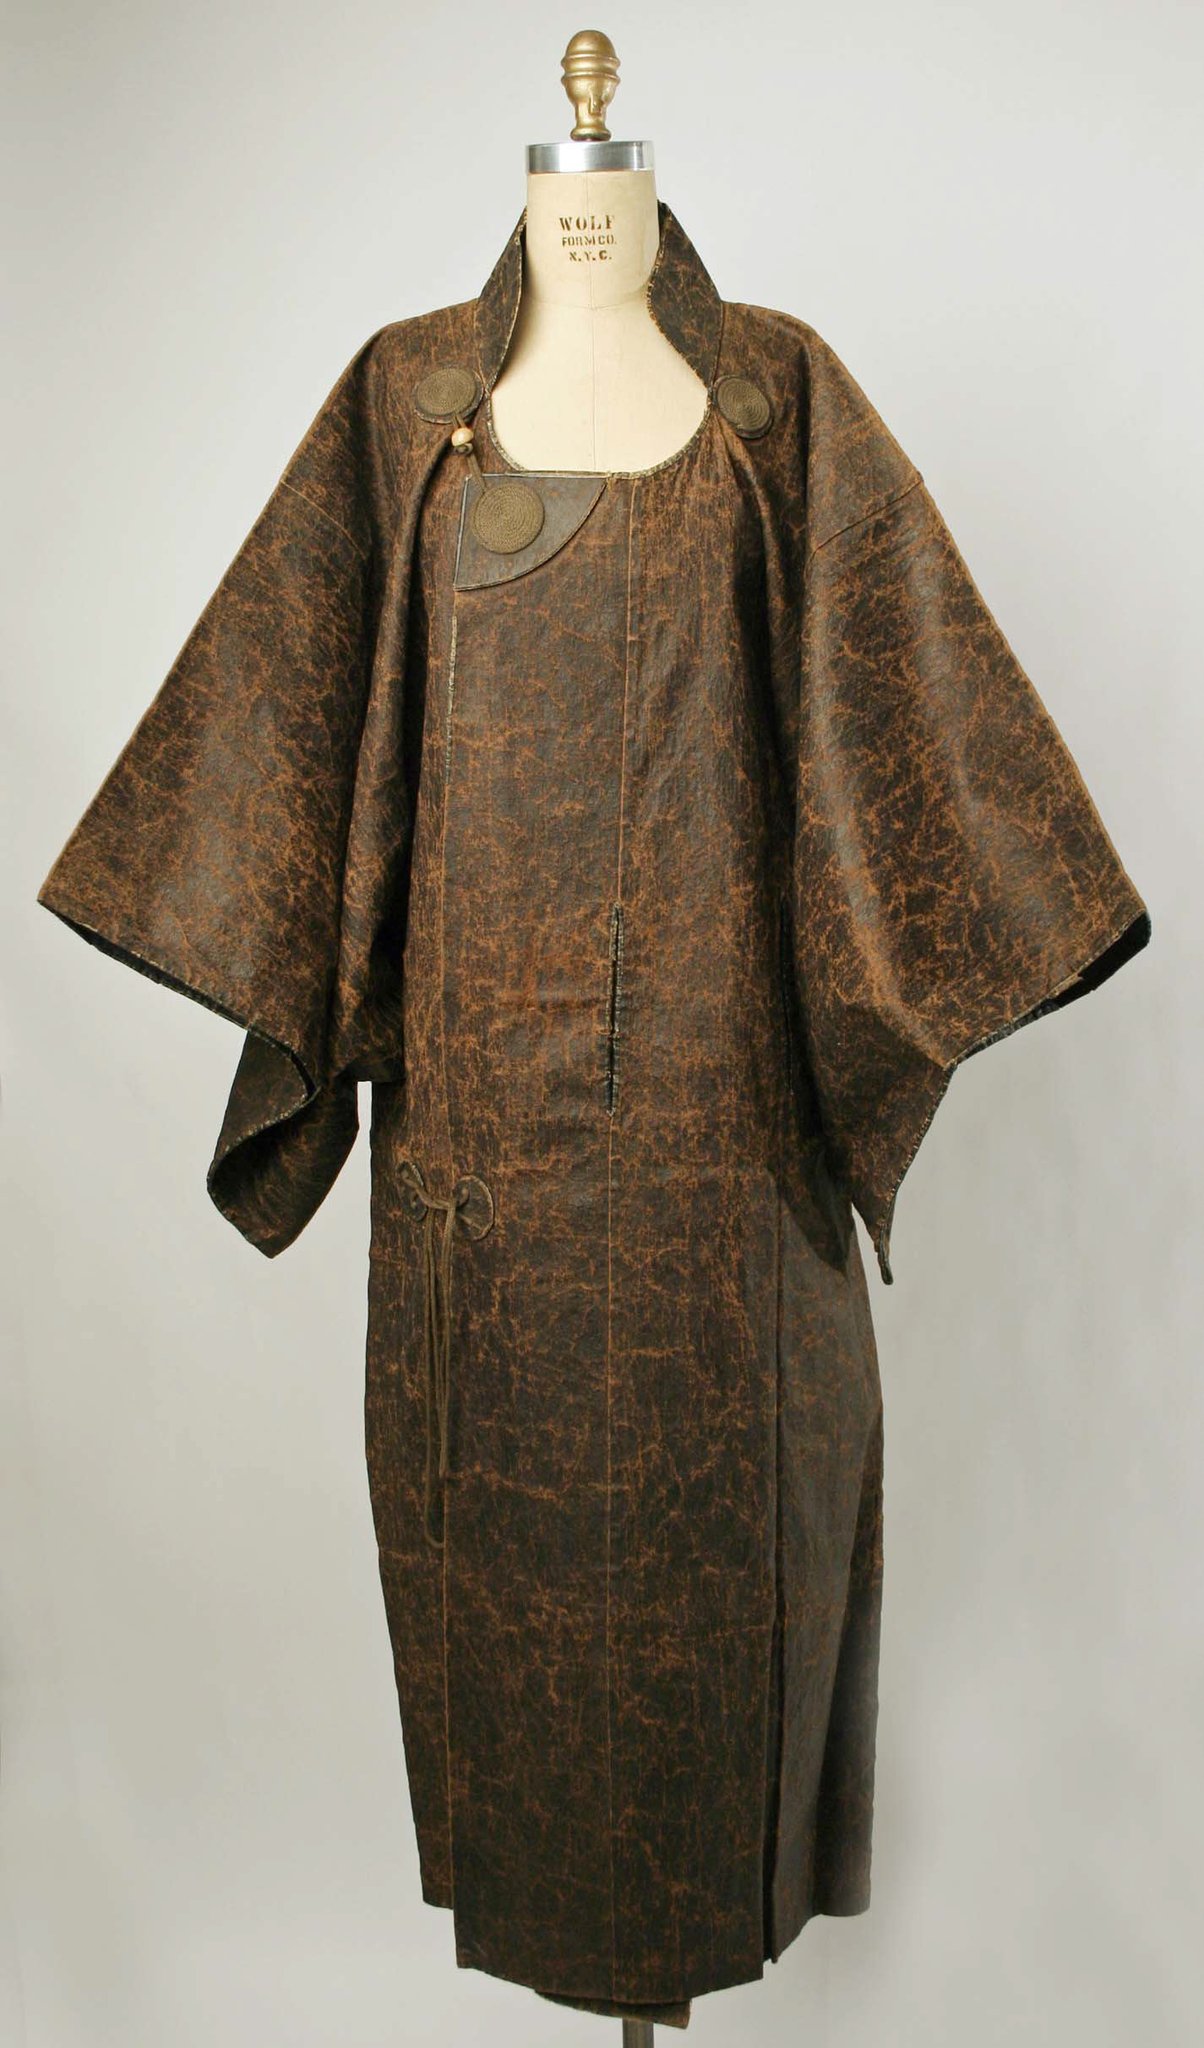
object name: raincoat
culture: japanese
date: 1790-1800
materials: glaze, linen, silk